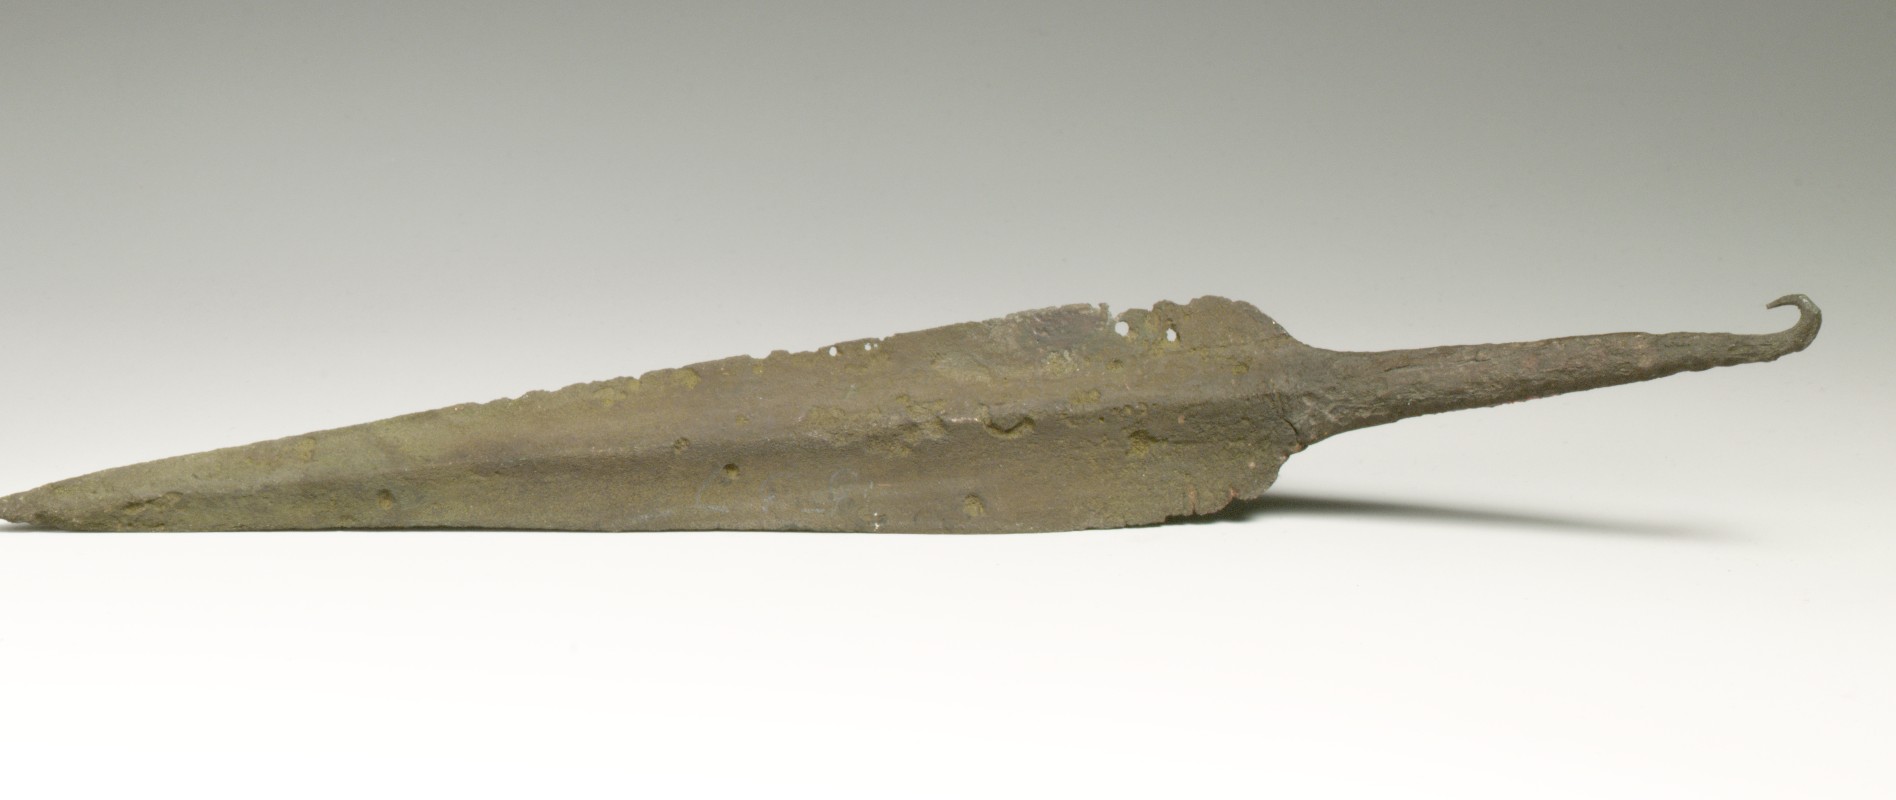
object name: dagger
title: Copper alloy spearhead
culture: cypriot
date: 2500-2000 BCE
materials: bronze